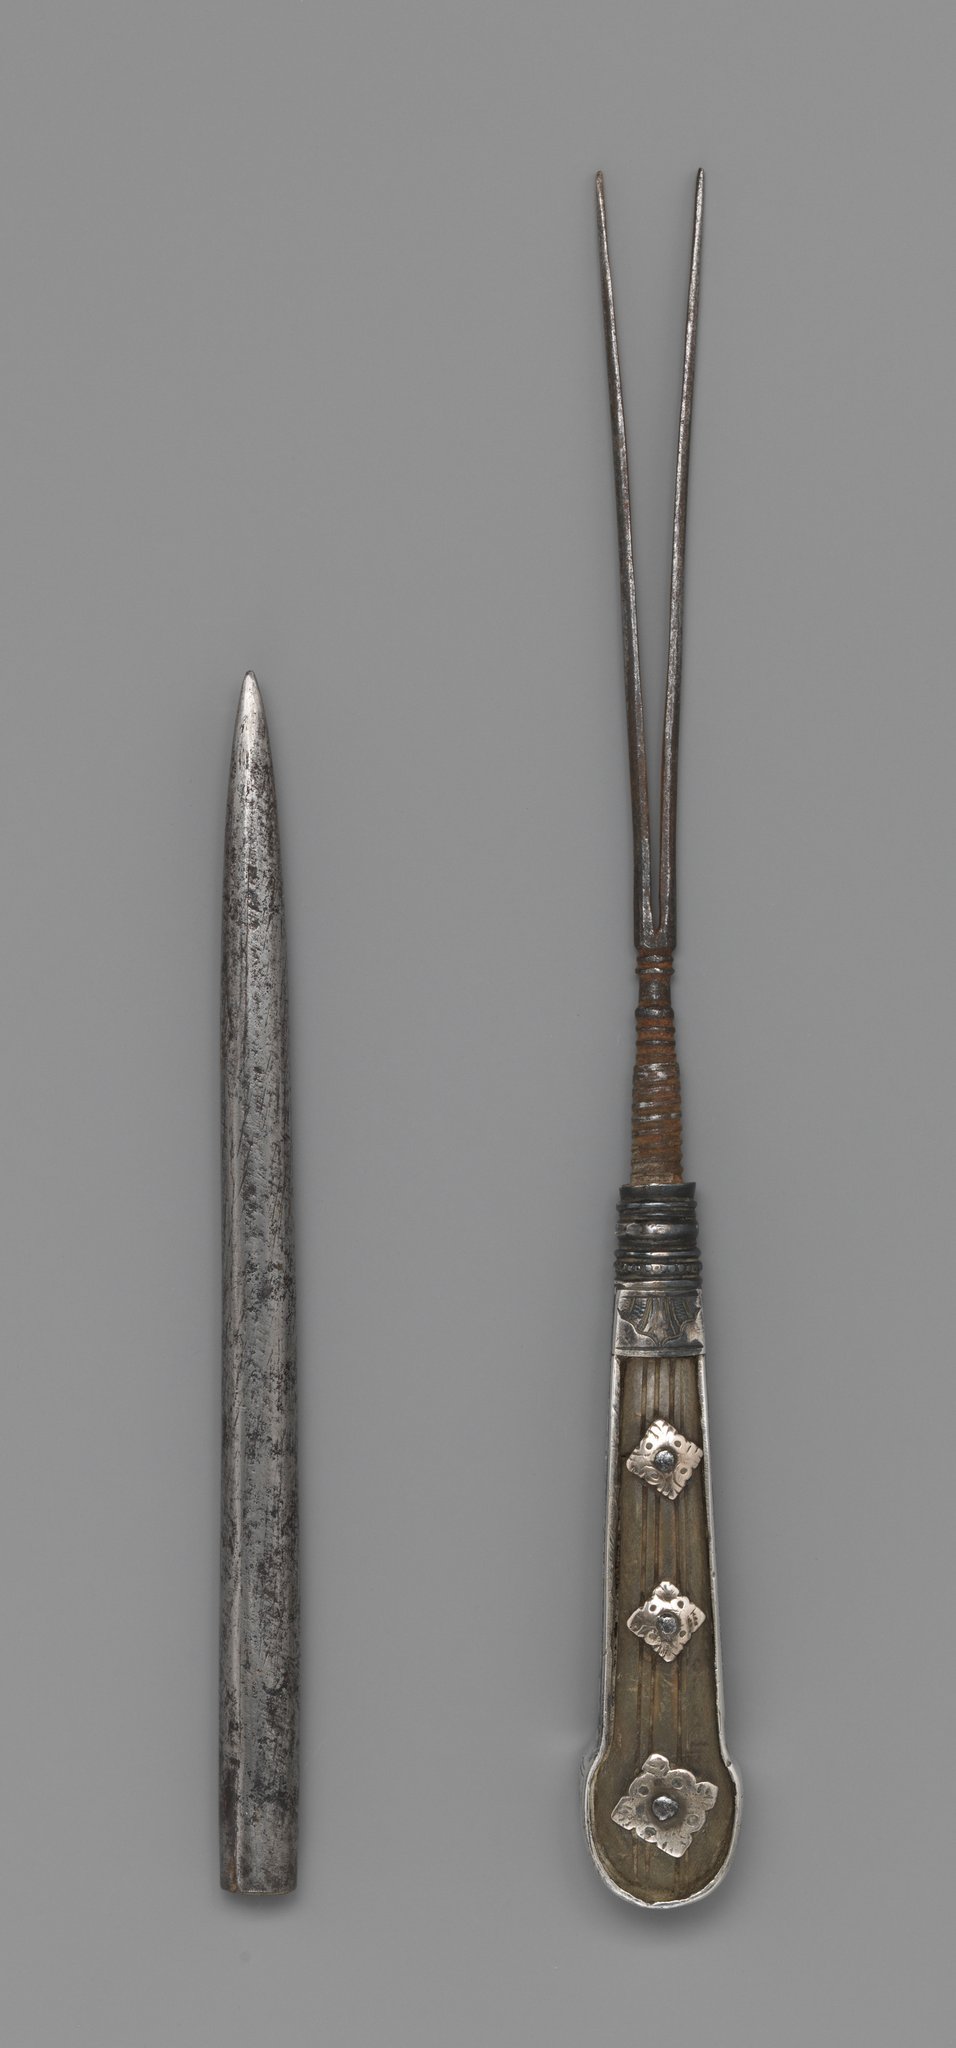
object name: whet steel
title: Whet-steel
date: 1701-1800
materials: horn, silver, steel